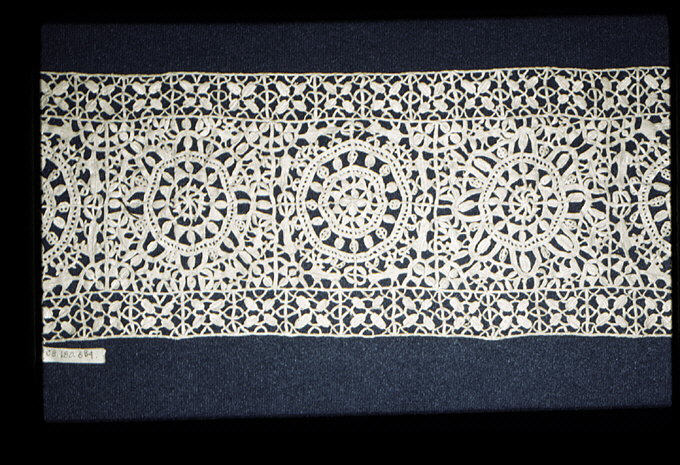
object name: border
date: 1601-1700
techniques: lace